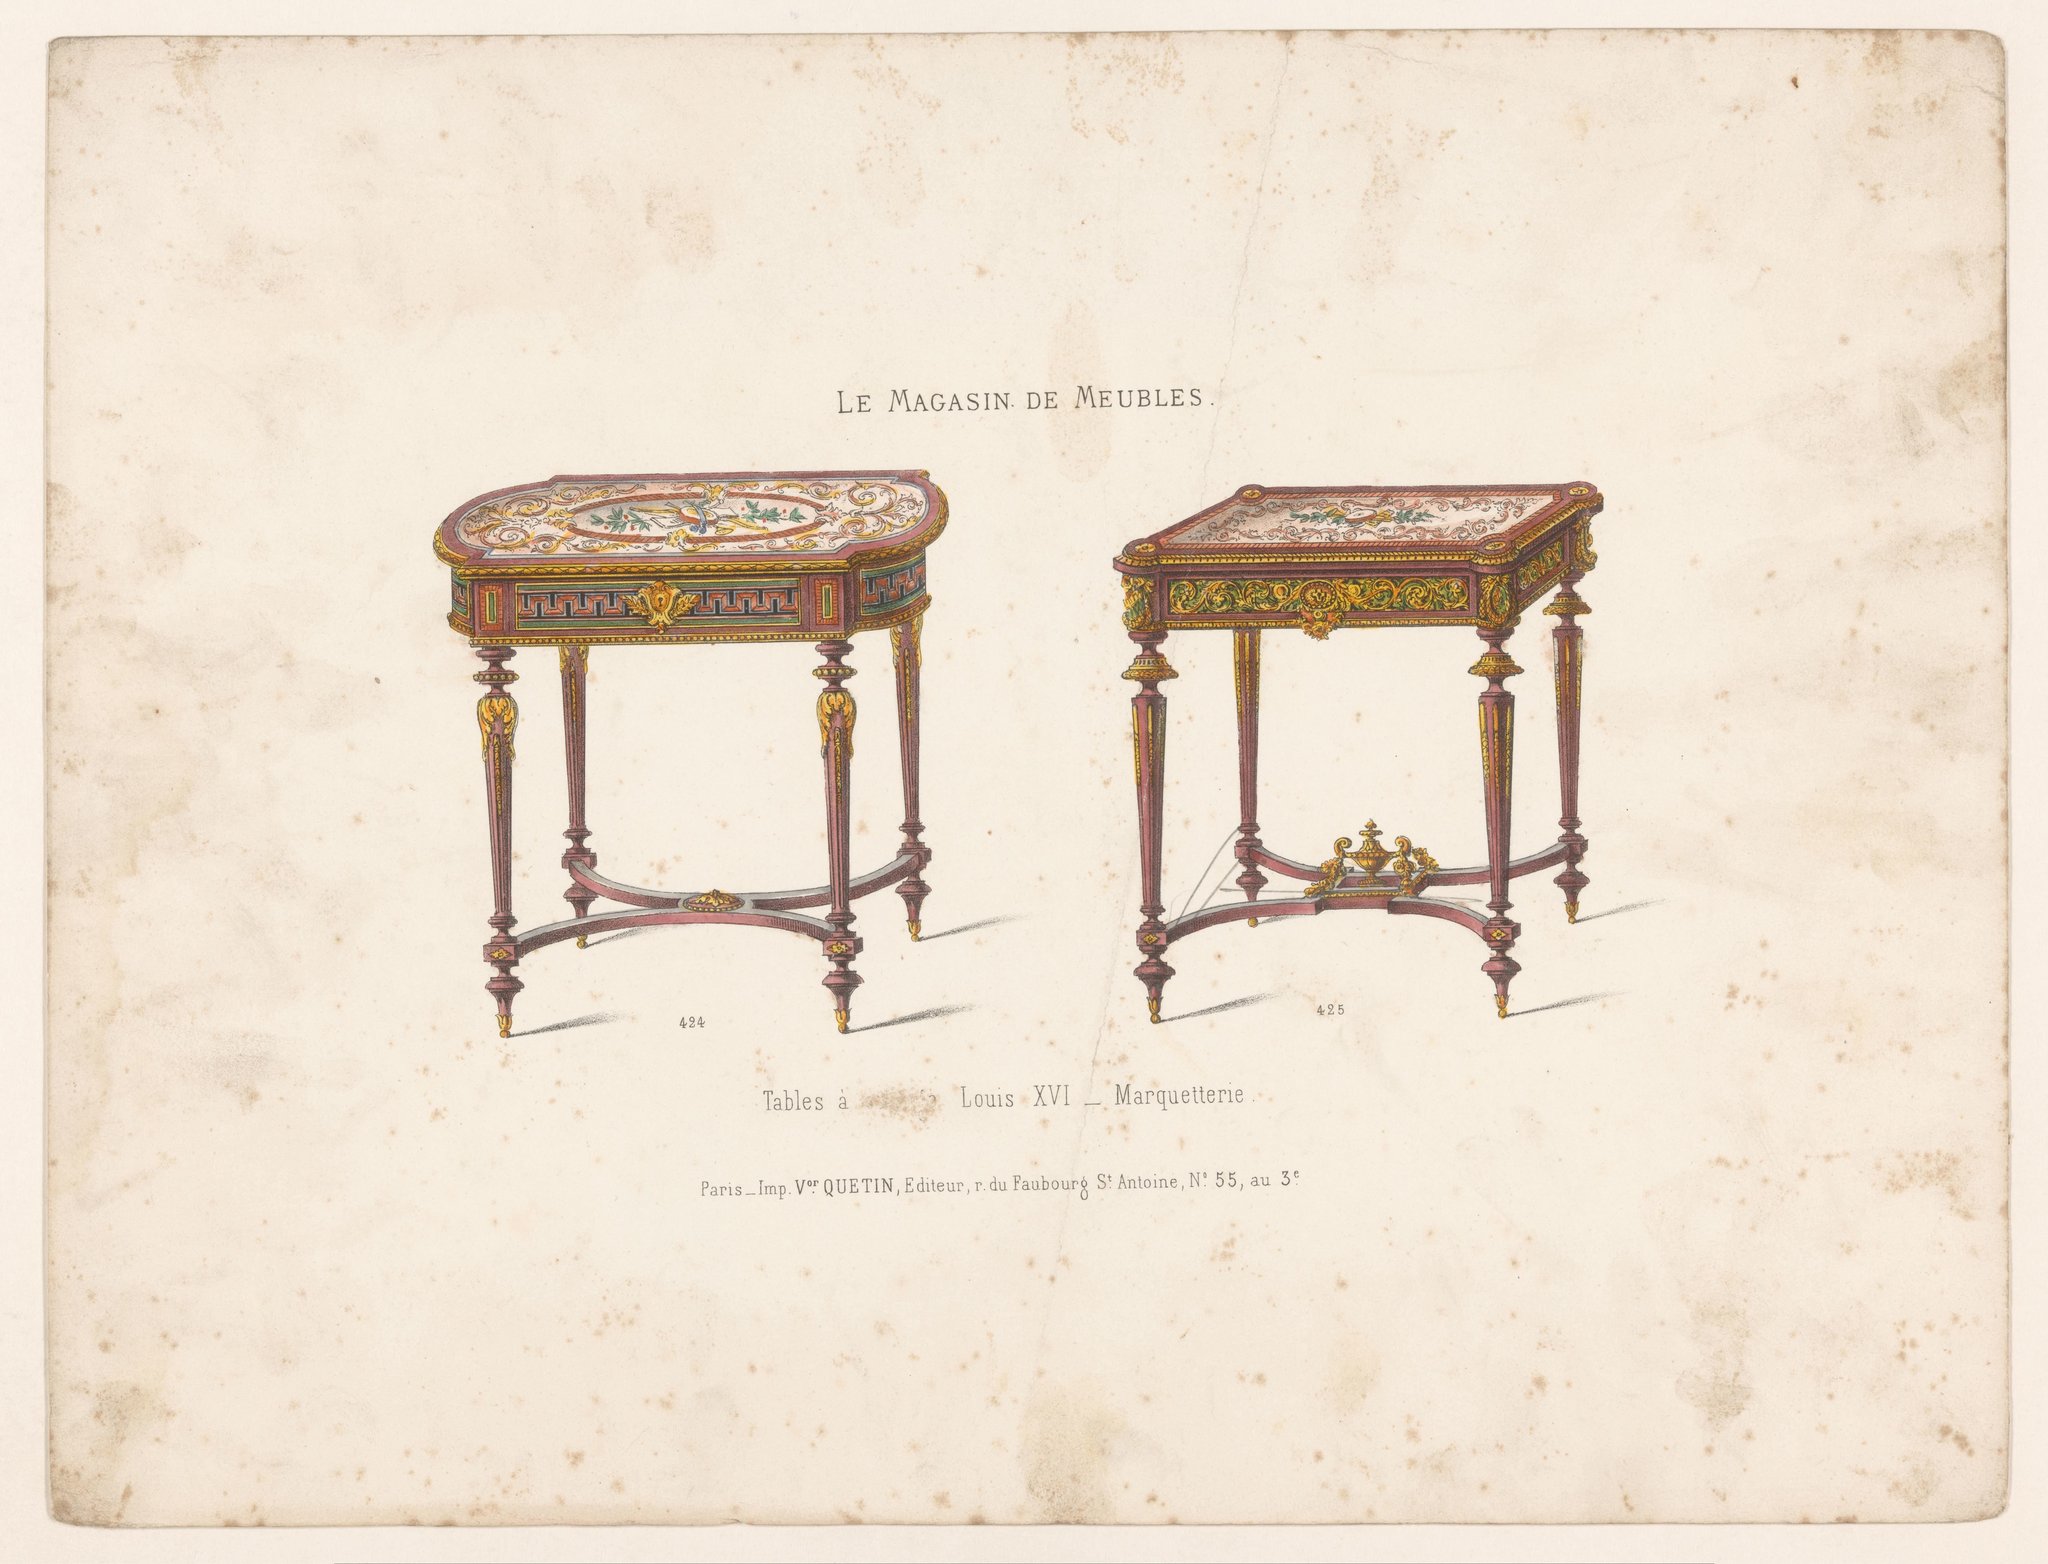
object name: print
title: Twee tafels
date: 1832-1877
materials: paper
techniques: hand coloring, lithograph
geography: paris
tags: table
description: Twee tafels met opklapbaar blad in de Lodewijk XVI-stijl.